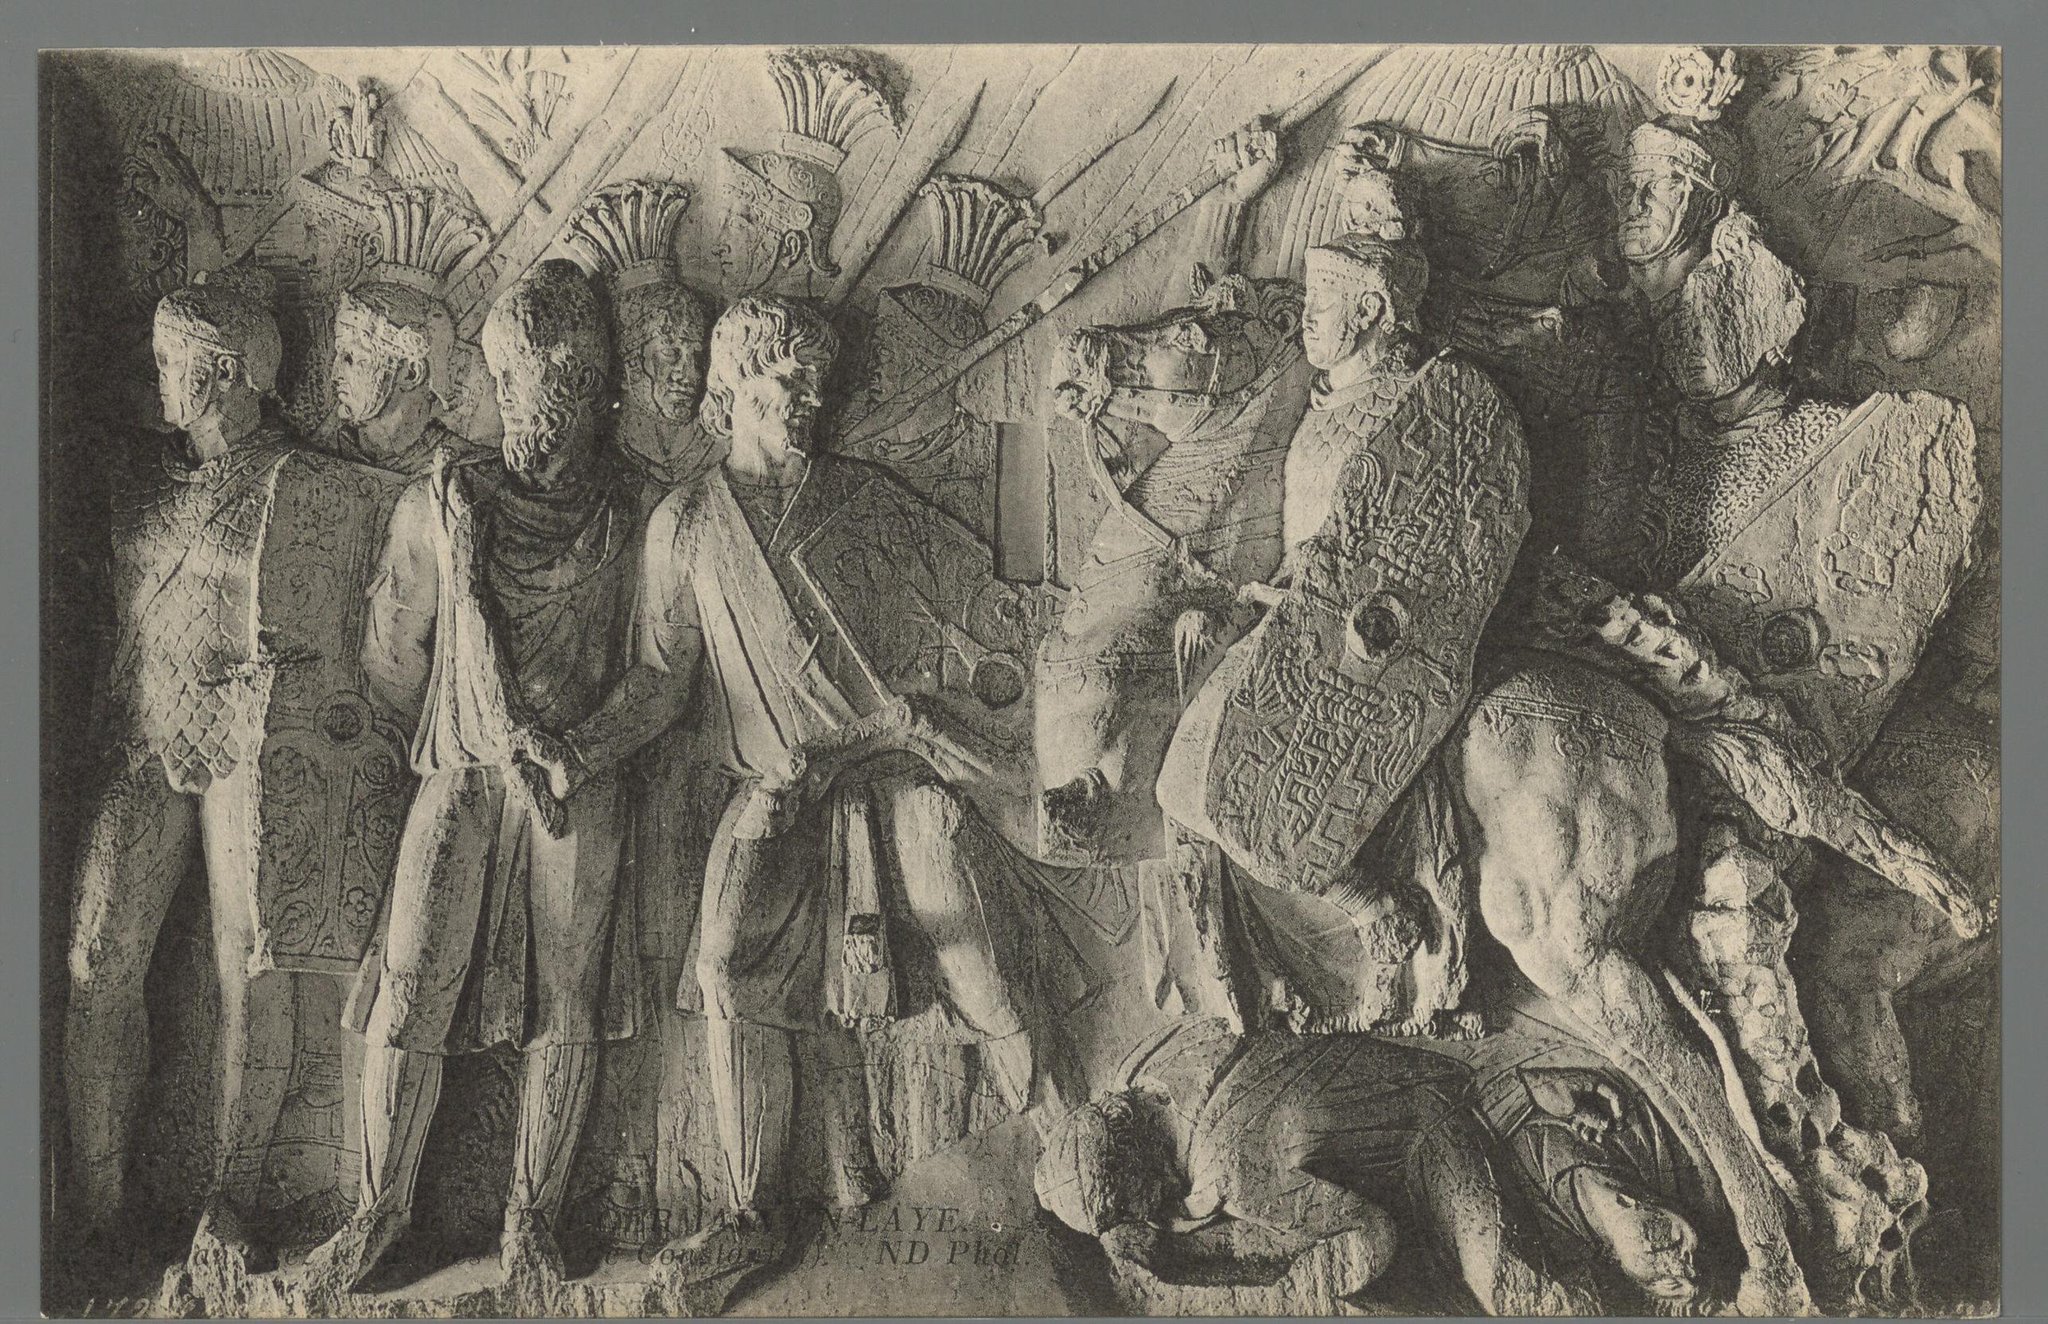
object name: ansichtkaart, prentbriefkaart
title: Musée de Saint-Germain-en-Laye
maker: Anonymous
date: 1903-1918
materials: cardboard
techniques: photograph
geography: paris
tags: triumphal arch, permanent exhibition, museum, sculpture